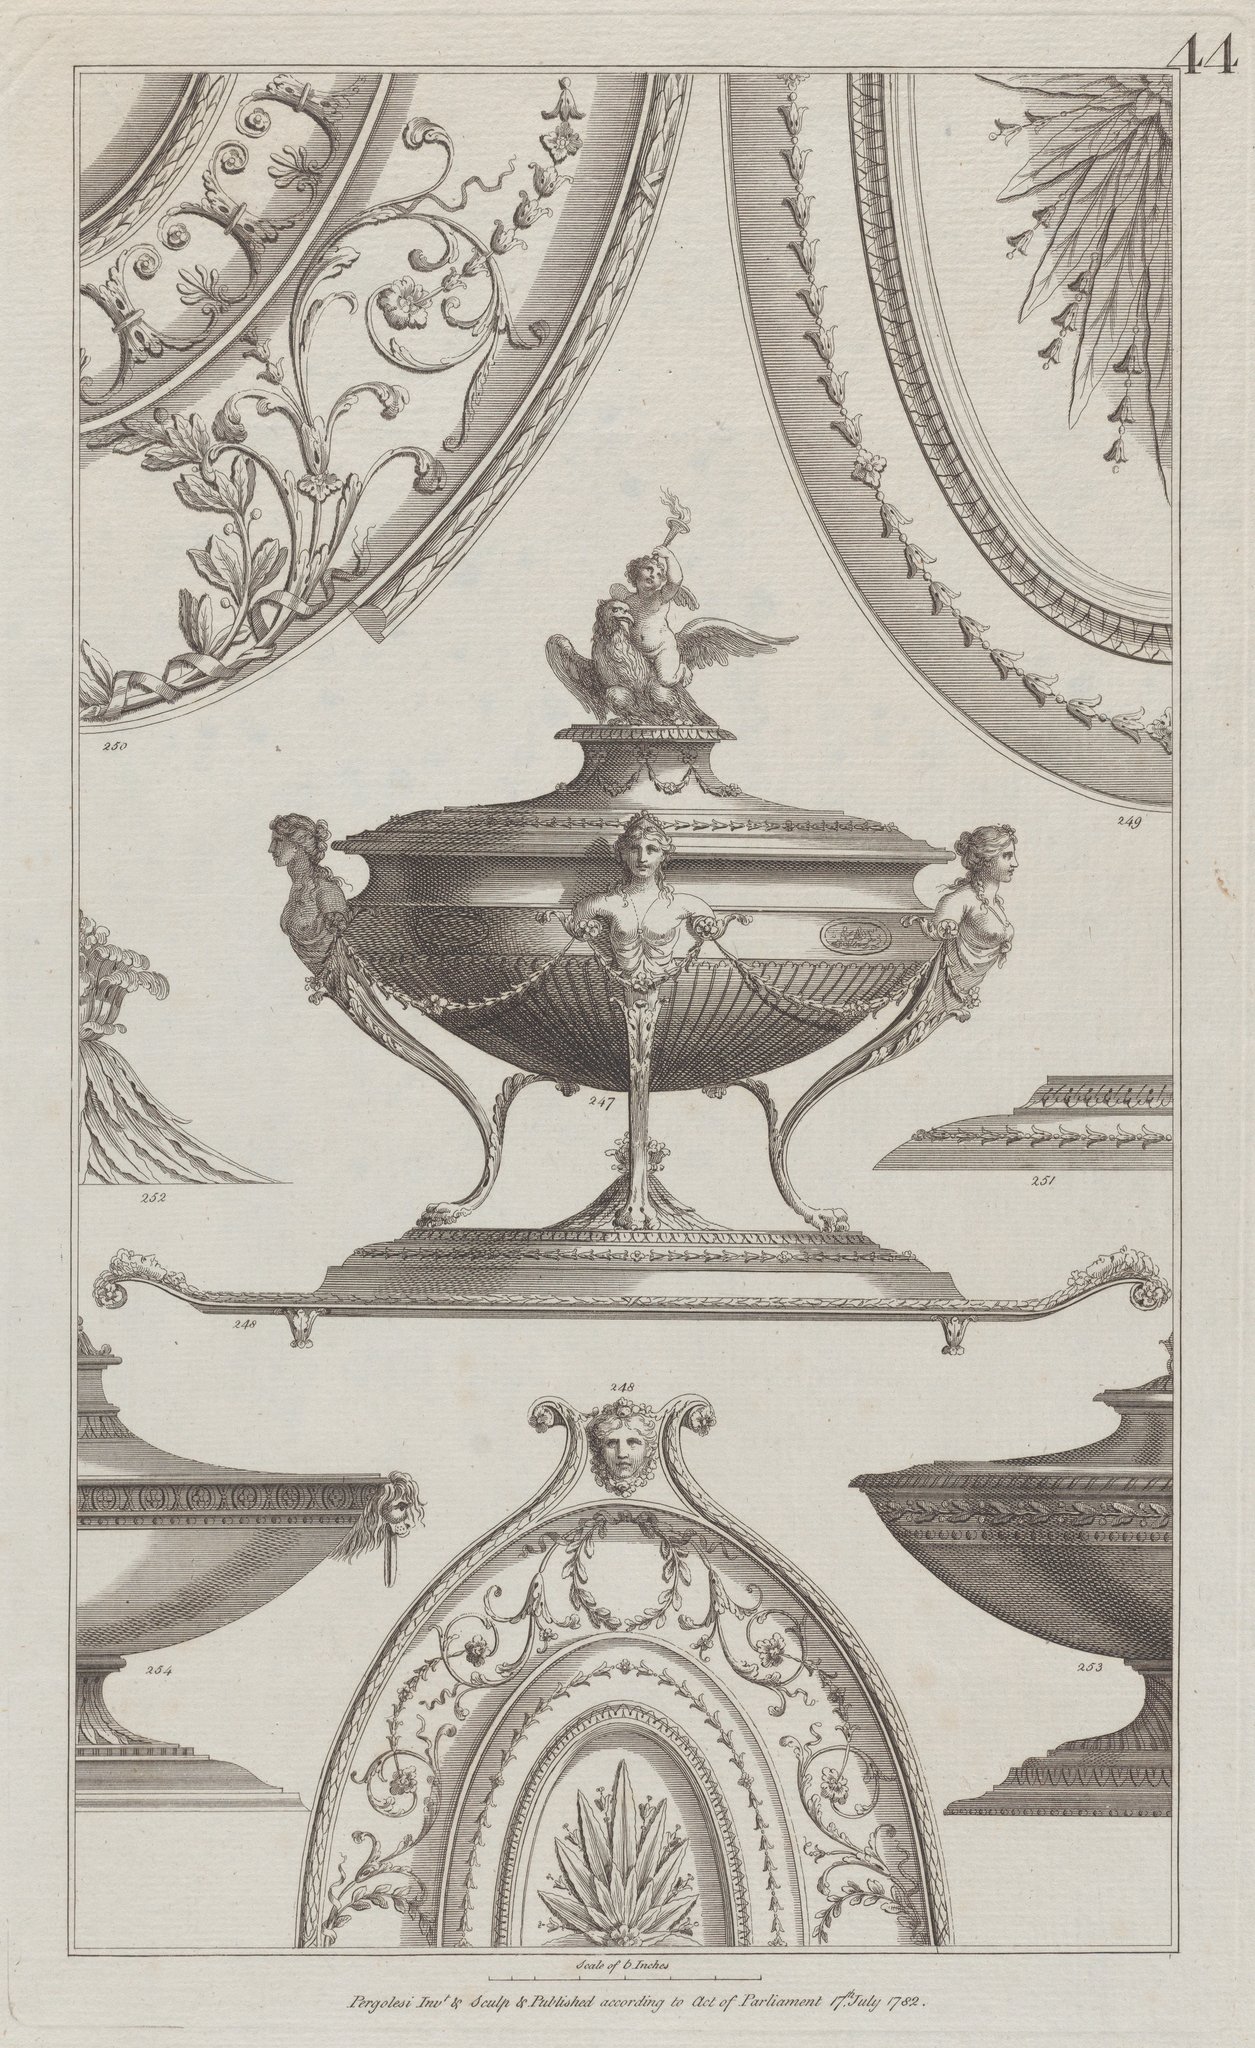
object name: print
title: Vases and Vessels, nos. 248–254, plate 44 from "Designs for Various Ornaments"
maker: michelangelo pergolesi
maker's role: artist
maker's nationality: italian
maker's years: 1760-1801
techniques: engraving, etching